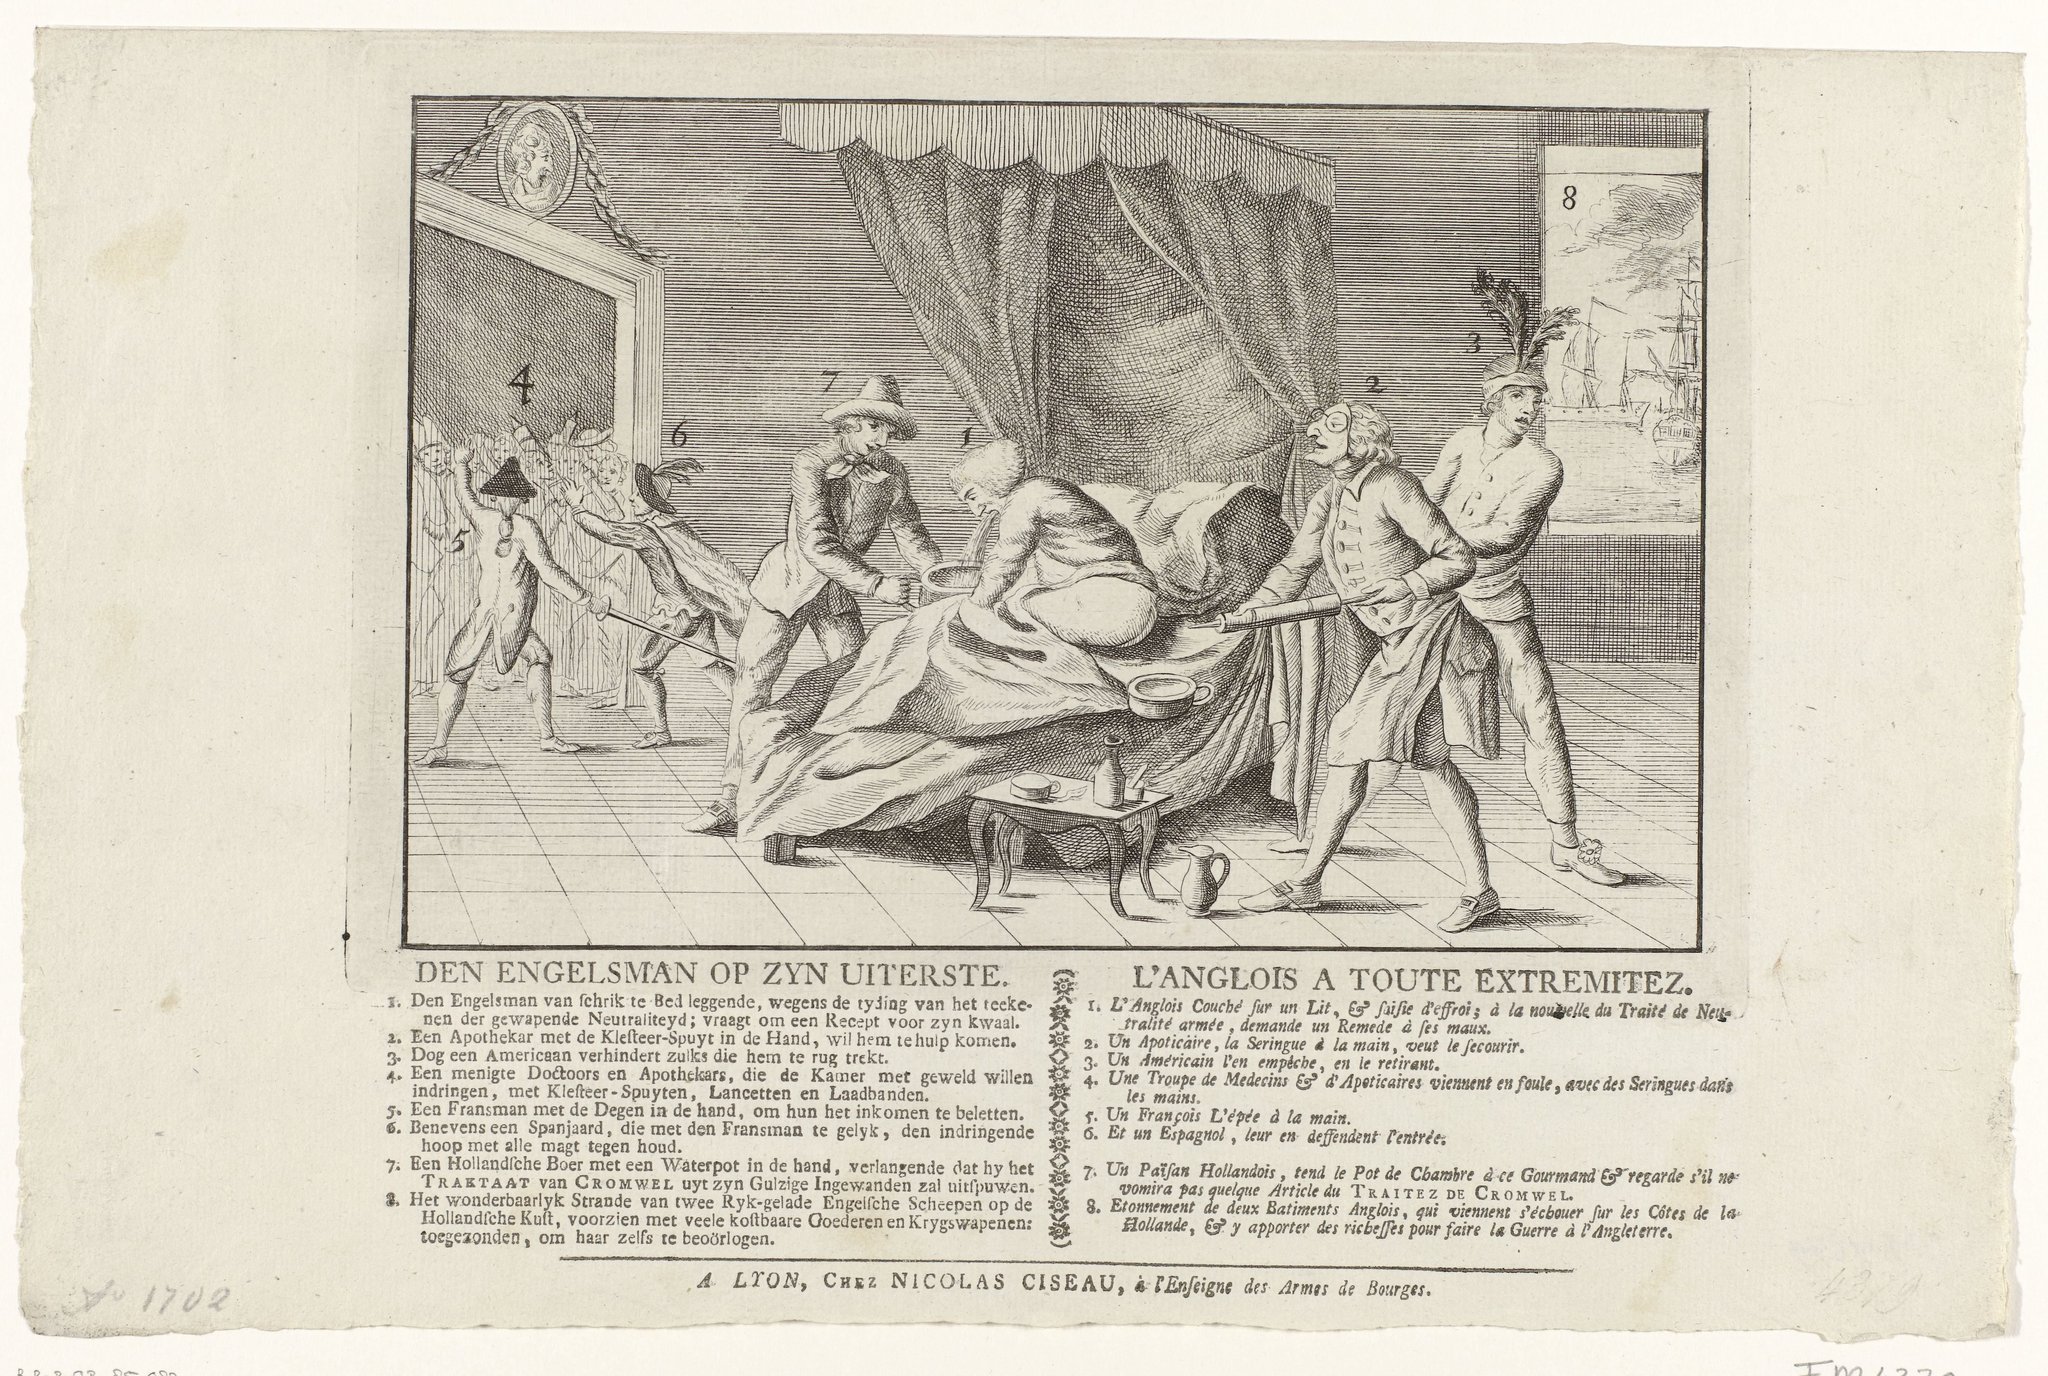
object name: print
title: Spotprent op de Engelsen, ca. 1780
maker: Anonymous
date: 1780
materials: paper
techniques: engraving, etching, letterpress printing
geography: northern netherlands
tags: london, george iii (koning van het verenigd koninkrijk), enema, squirt, vomiting, fourth anglo-dutch war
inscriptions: collector's mark: Lugt 2228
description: Spotprent op de Engelsen in 1780. Een Engelsman, mogelijk koning George III, ligt ziek op bed. Een apotheker maakt zich klaar om de koning met een klisteerspuit een lavement toe te dienen, maar wordt tegengehouden door een Amerikaan. De Hollander houdt een pot vast waarin de Engelsman braakt. Op het blad onder de plaat de verklaring van de cijfers 1-18 in het Nederlands en Frans.